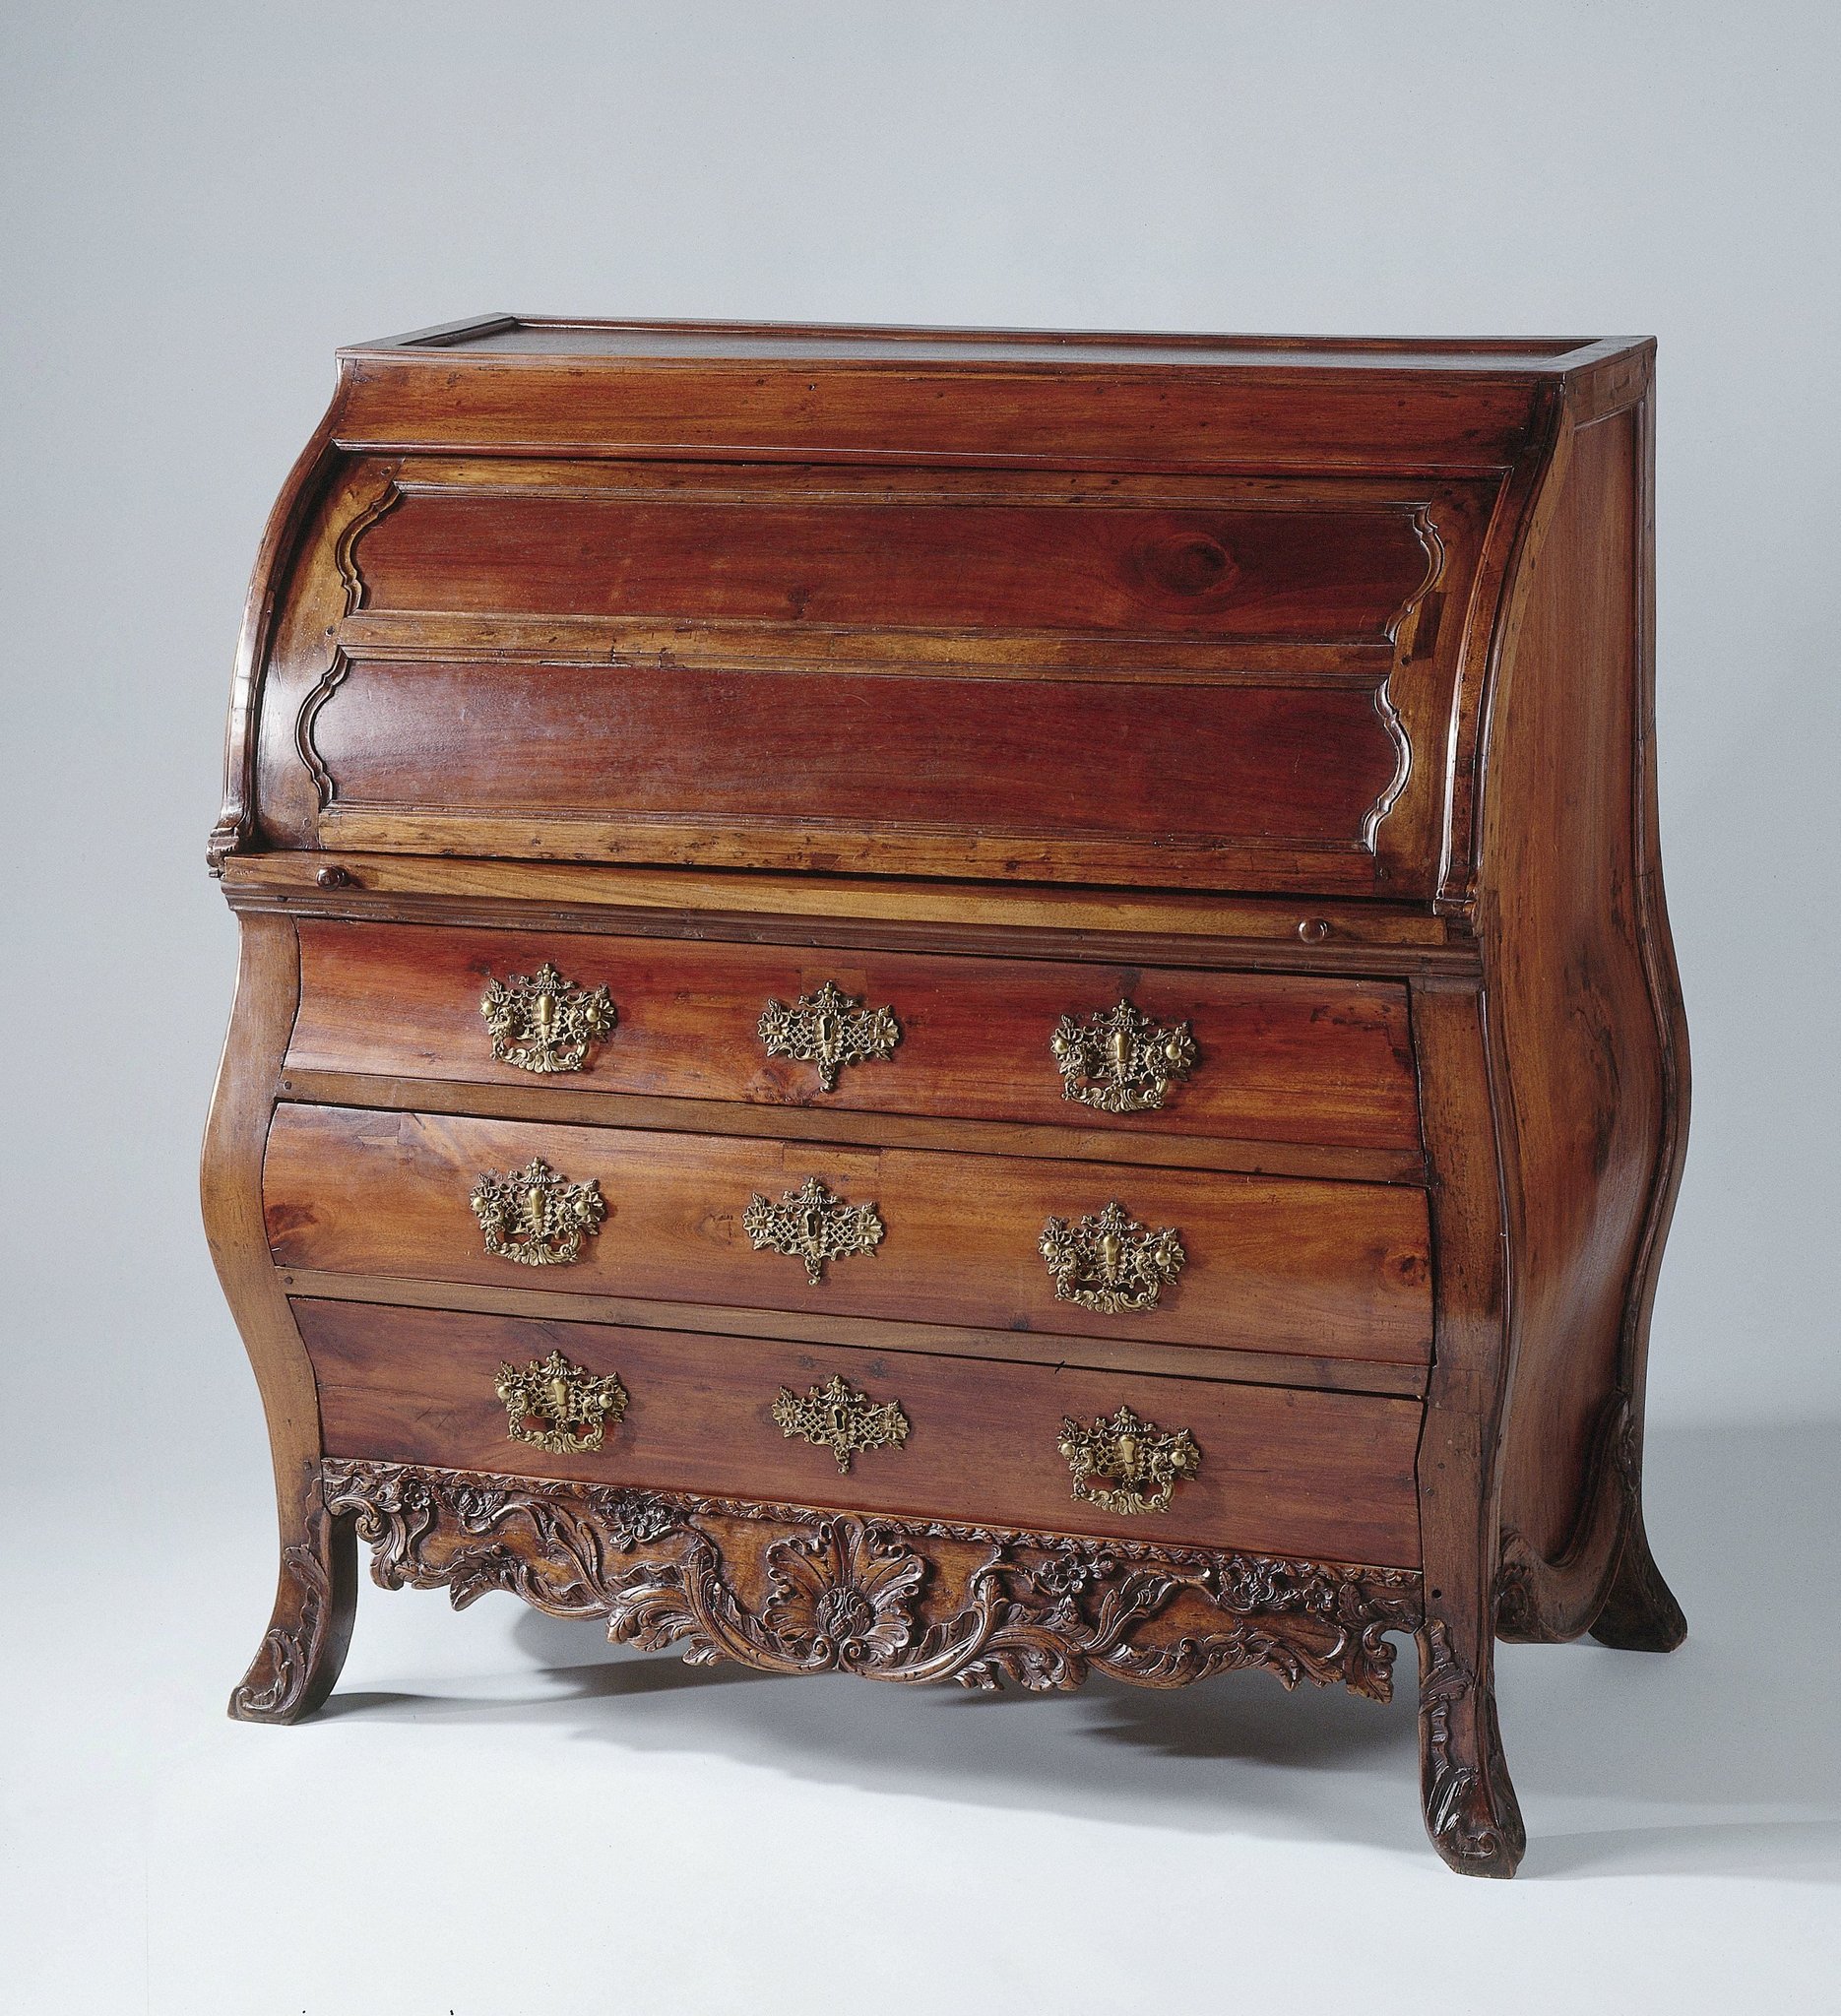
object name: cylinderbureau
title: Cylinderbureau met messing beslag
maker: Anonymous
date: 1740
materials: wood, brass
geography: indonesia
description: Cylinderbureau van Andaman padoek met messing beslag.